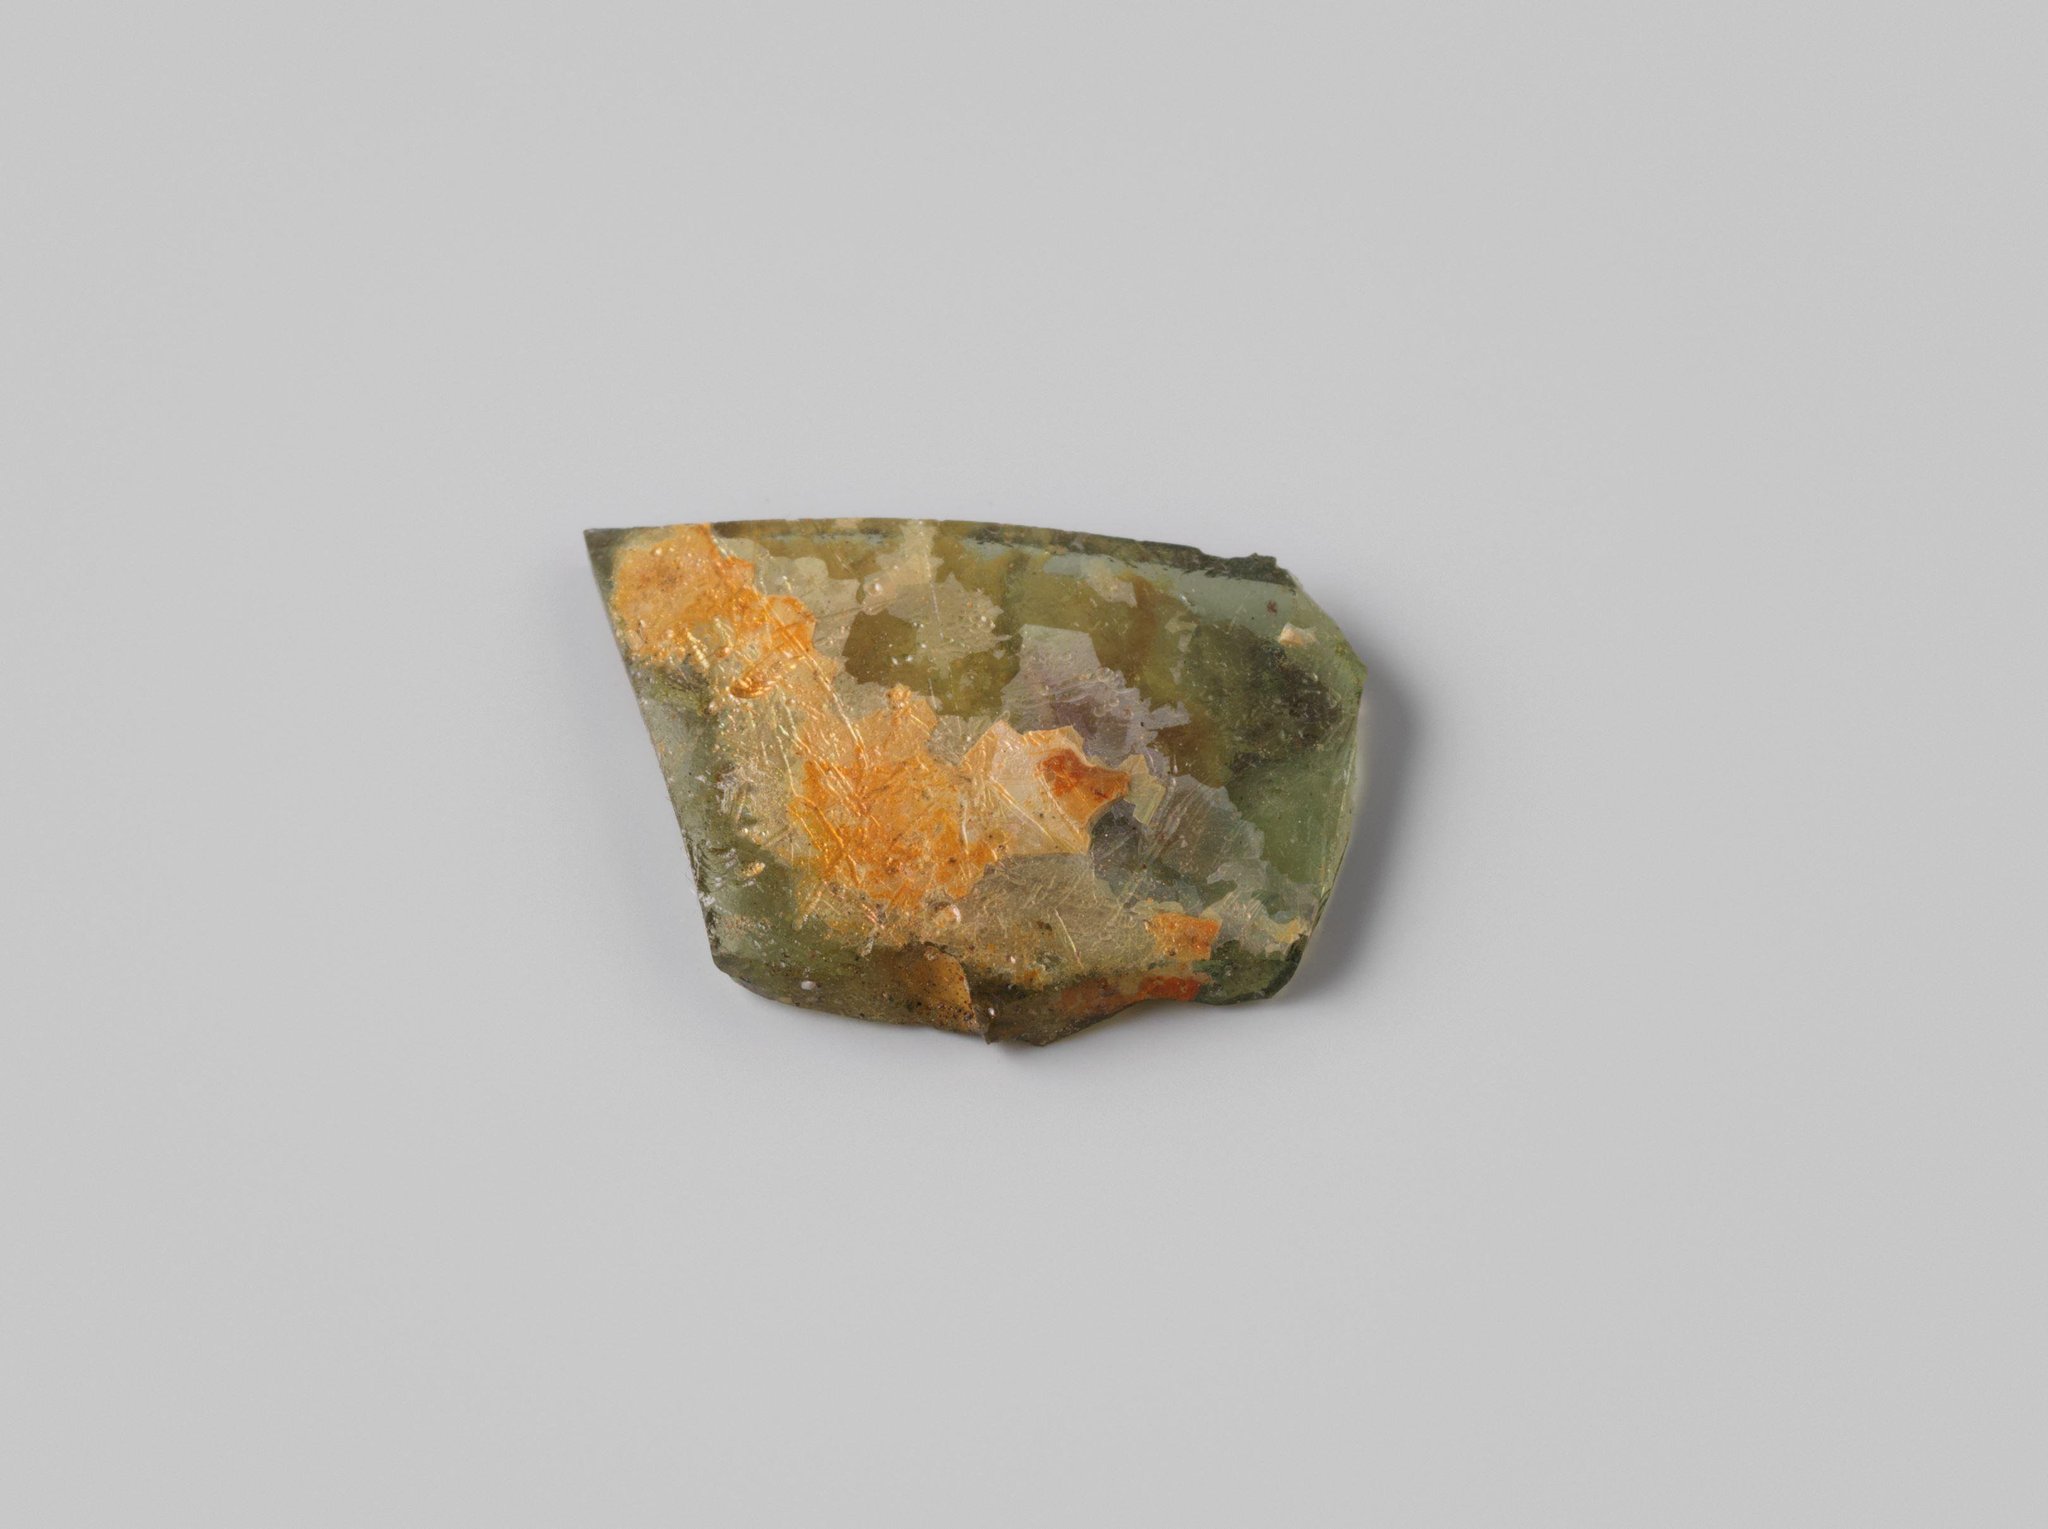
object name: sherd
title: Scherf van een wijnfles uit het wrak van de Oost-Indiëvaarder Hollandia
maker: Anonymous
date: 1700-1743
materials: glass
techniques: green glass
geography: netherlands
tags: verenigde oostindische compagnie, hollandia (schip), annet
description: Typologically not identifiable, belly, fragment.